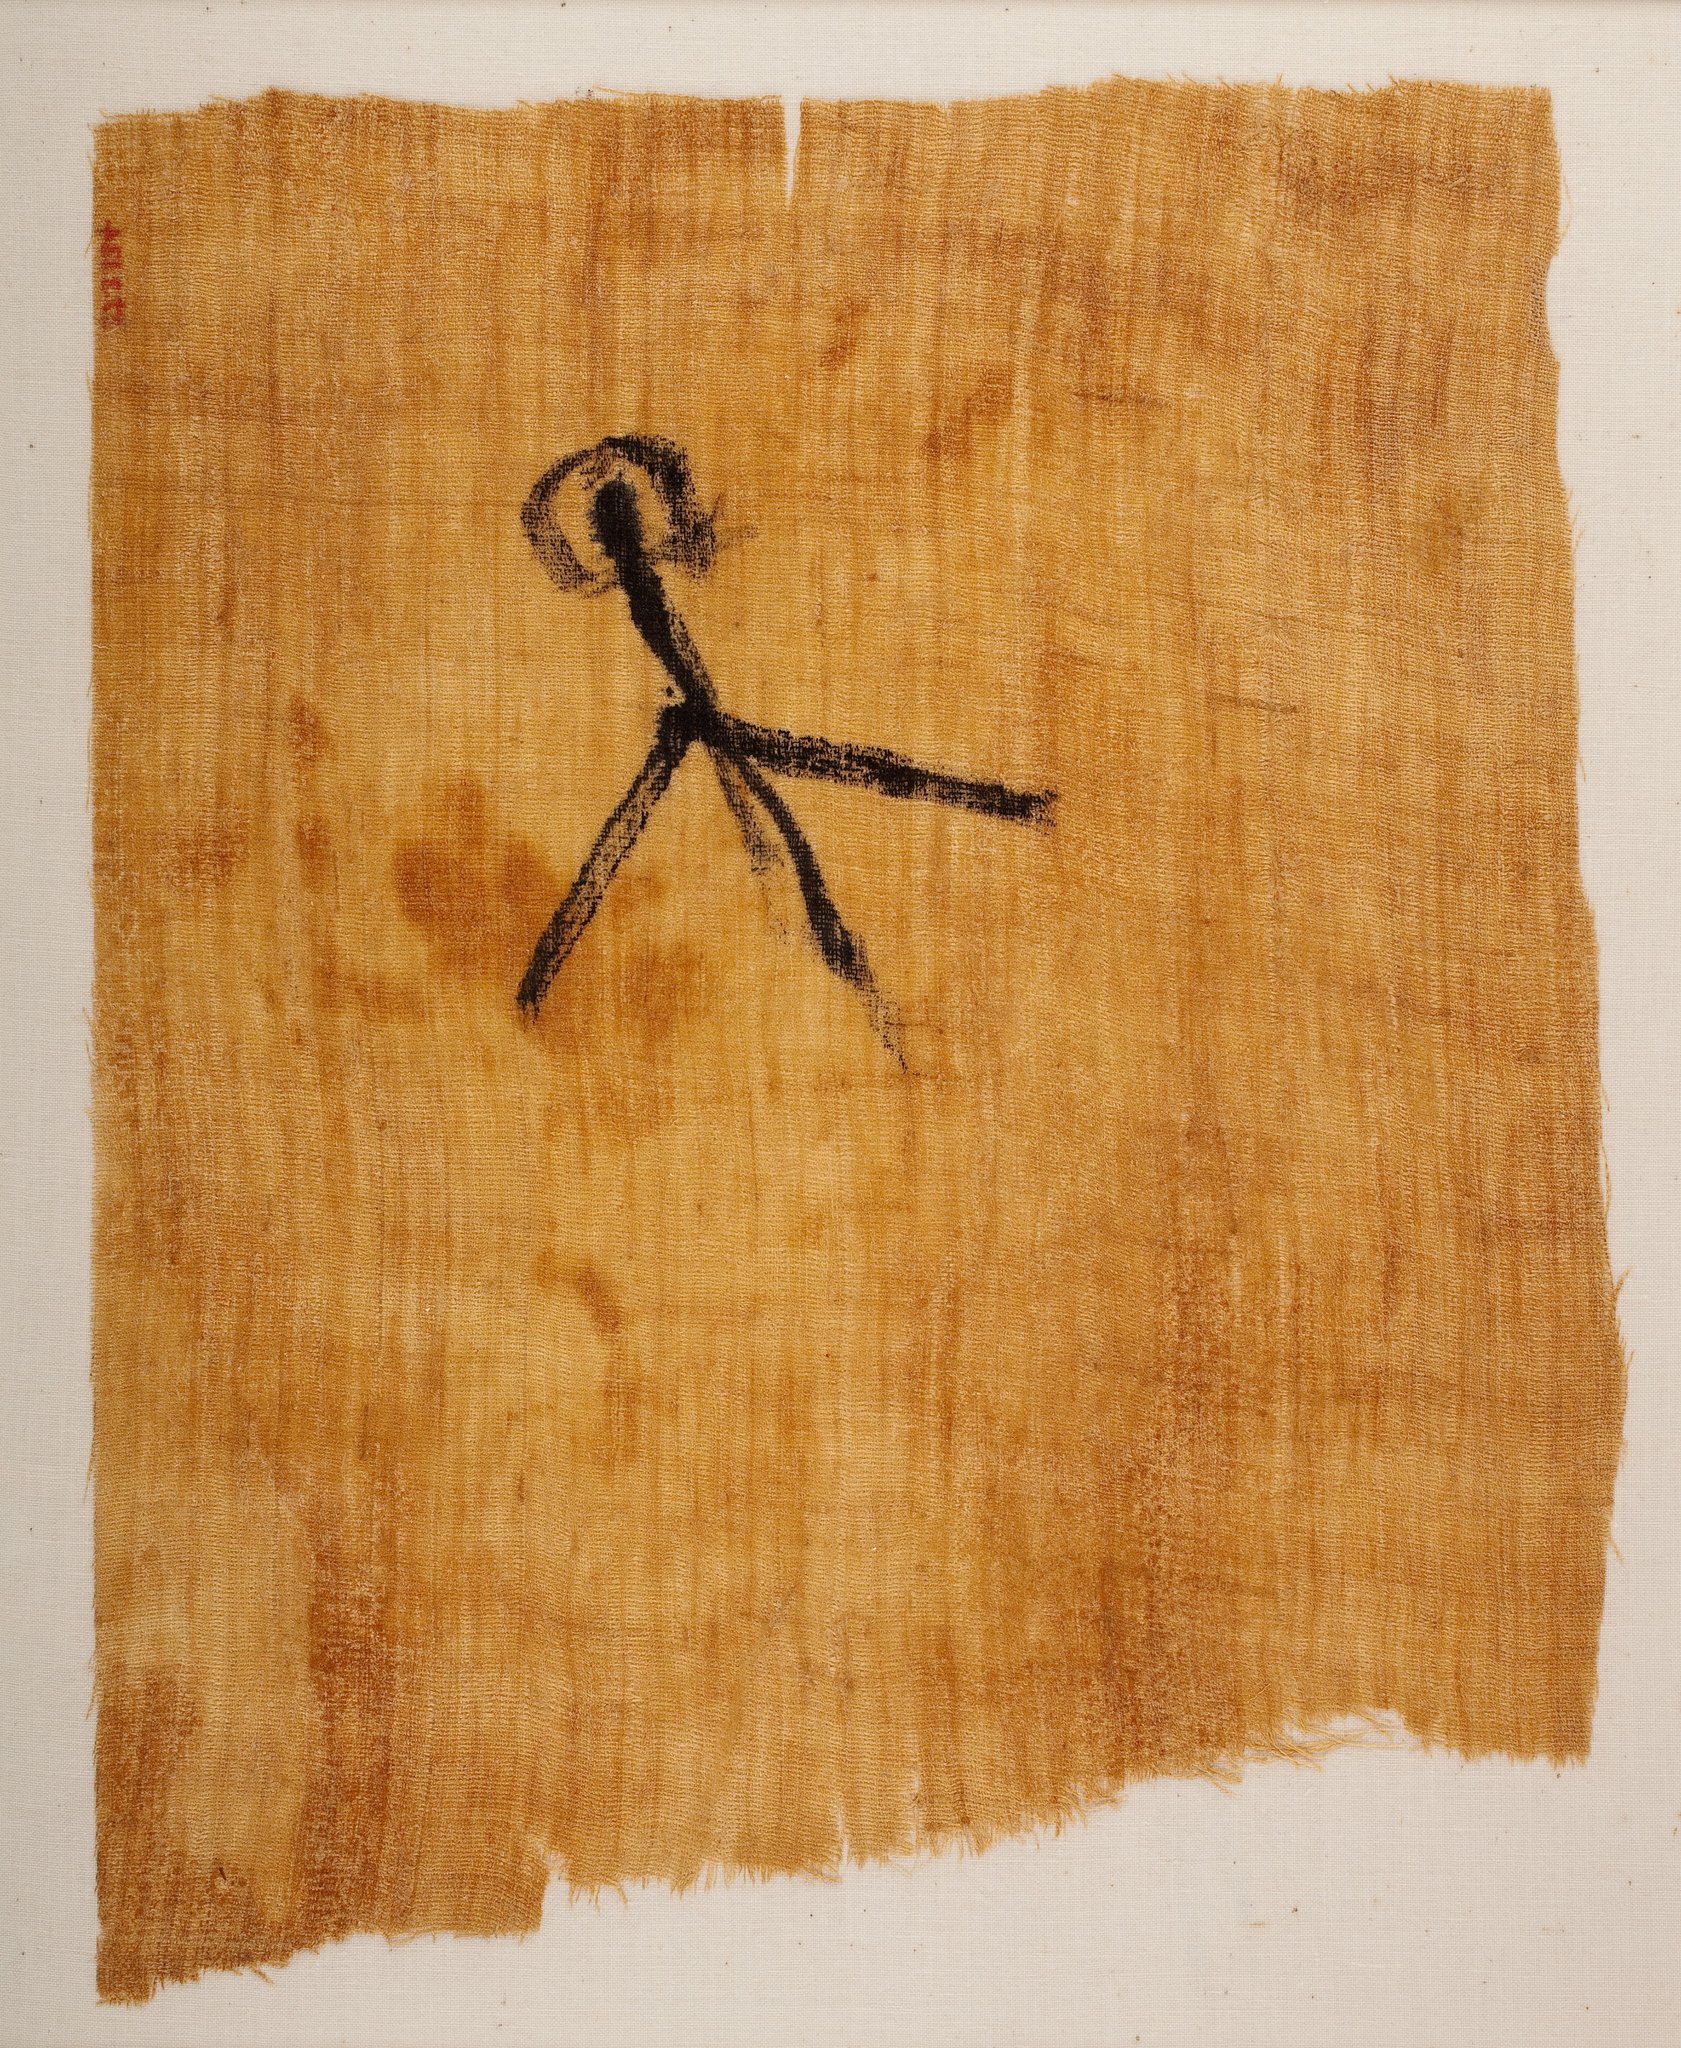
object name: linen mark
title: Linen mark (Type XXXVII)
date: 1961-1917 BCE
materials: linen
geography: egypt